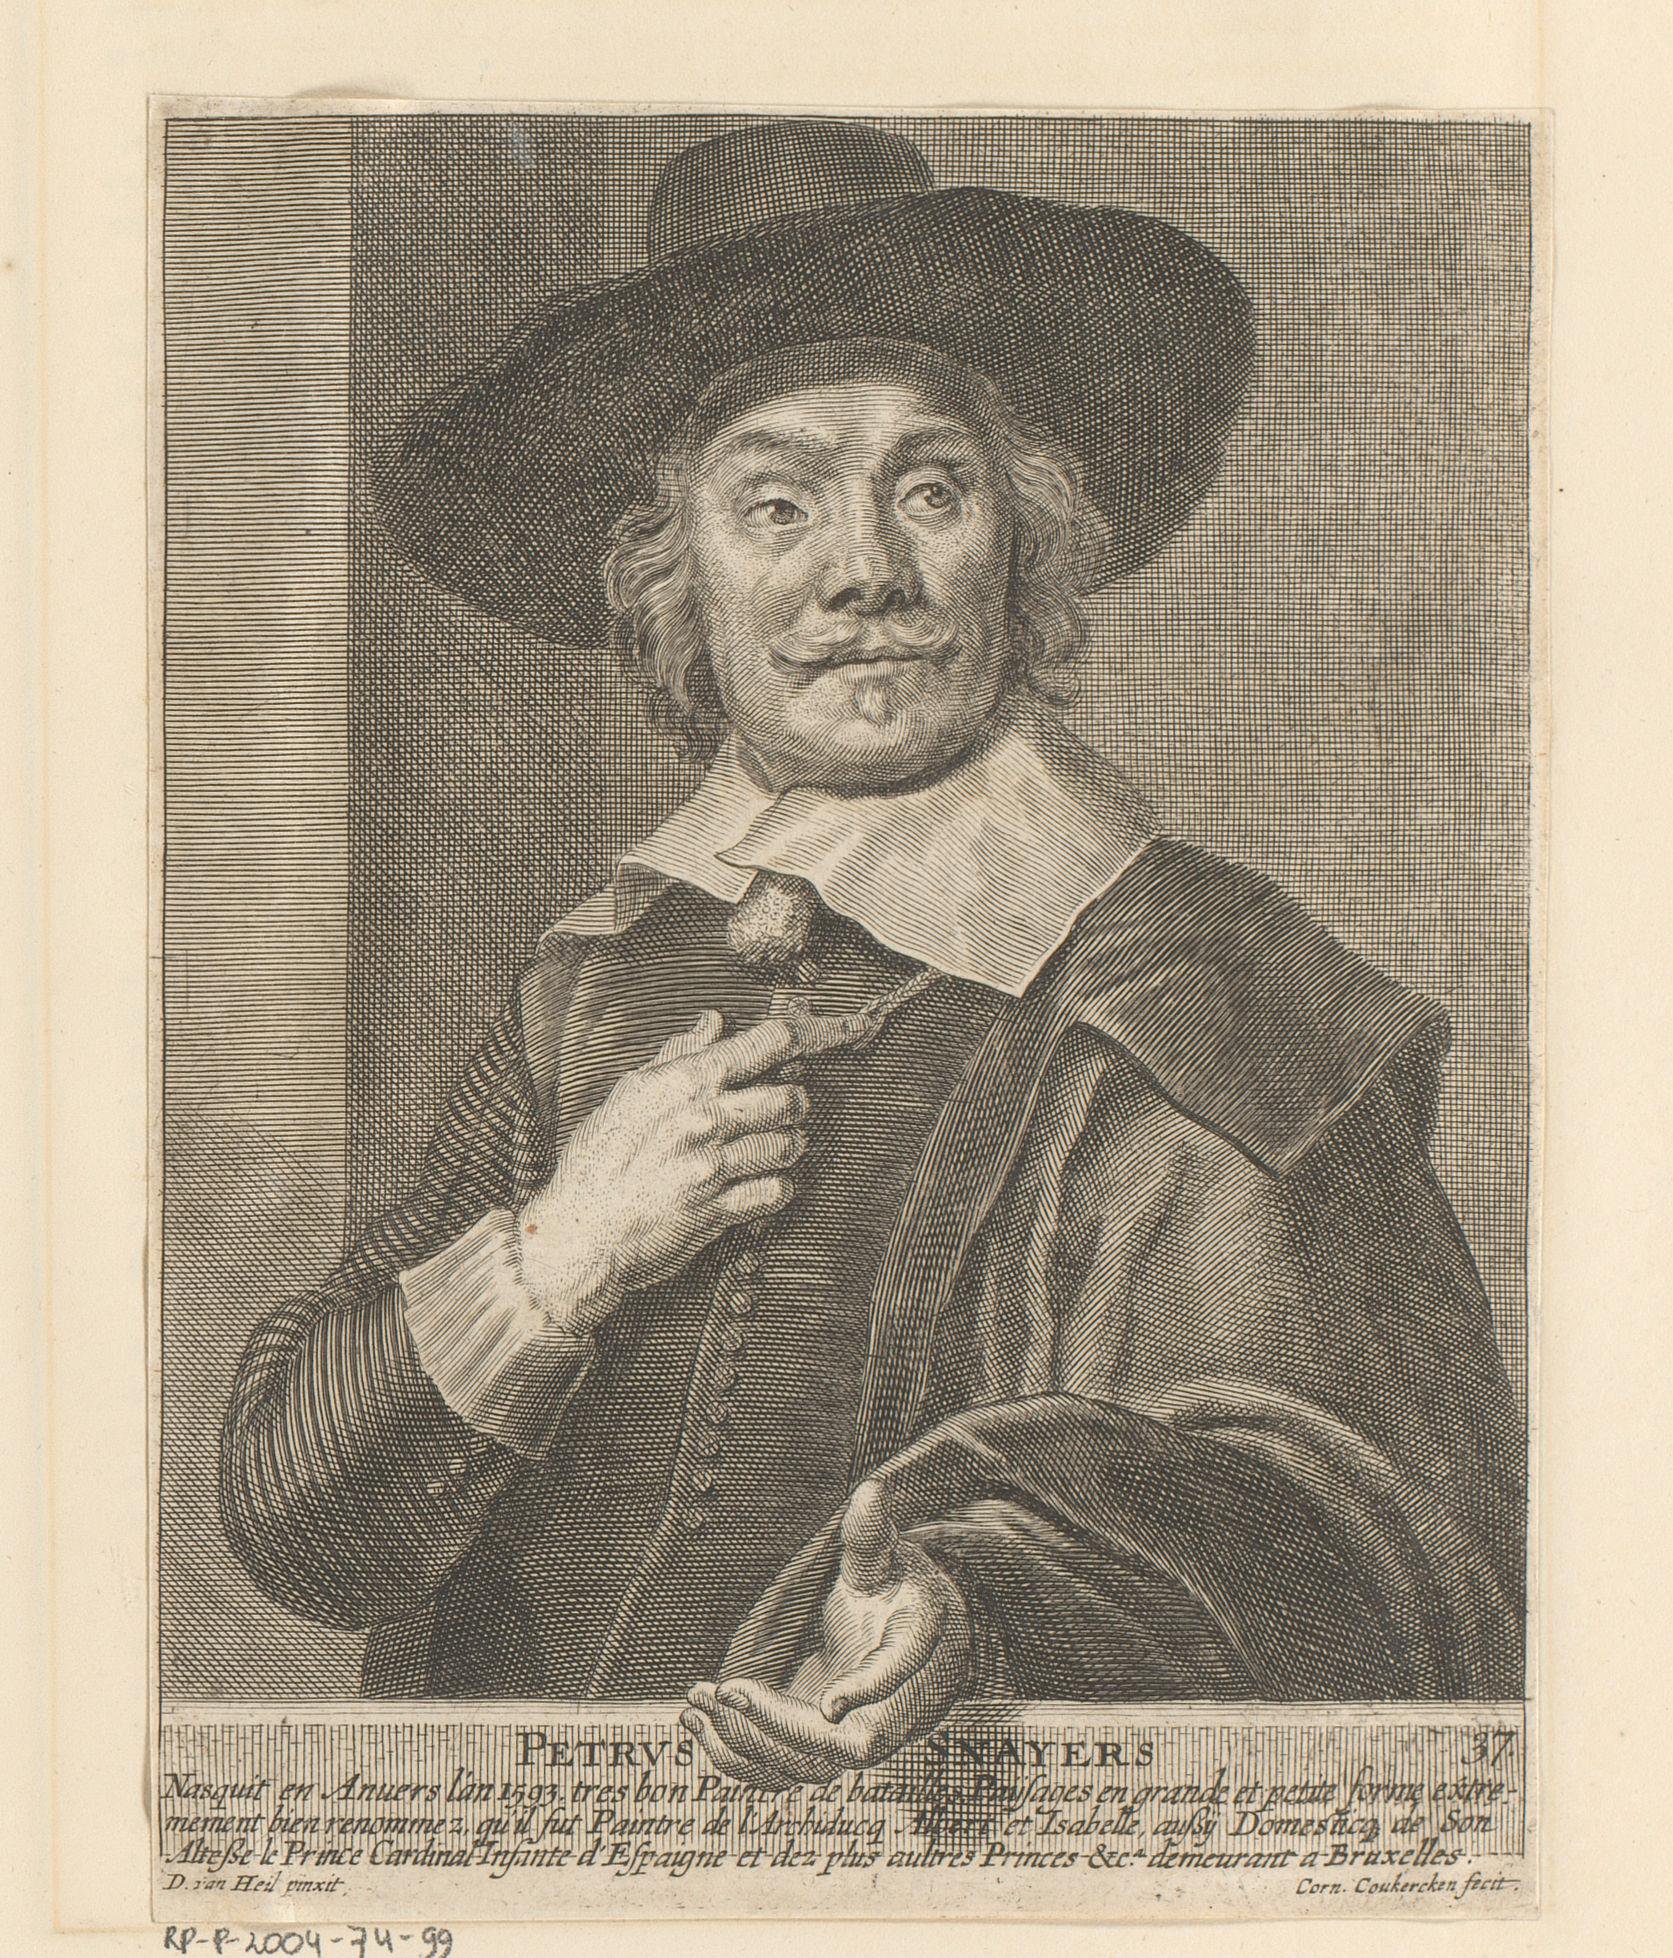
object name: print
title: Portret van Peter Snayers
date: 1649-1662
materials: paper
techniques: engraving, etching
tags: brussels, peeter snayers, historical persons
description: Prent mogelijk uit: Meyssens, Joannes. Image de divers hommes desprit sublime qui par leur art et science deburovent vivre eternellement et des quels la louange et renommée faict estonner le monde. 2 dln. Antwerpen: Joannes Meyssens, 1649, dl. 1, p. 54. Andere staat van prent gebruikt in: Bie, Cornelis De. Het gulden Cabinet vande edel vry schilder const, inhoudende den lof vande vermarste schilders, architecte, beldthowers ende plaetsnyders van dese eeuw. Antwerpen: Joannes Meyssens, 1662 [1661 foutief op titelpagina], p. 221. De samensteller heeft deze prent in het album geplakt als illustratie bij: Pilkington, Matthew en Johann Heinrich Füssli. A dictionary of painters, from the revival of the art to the present period. 4 dln. Londen: John Crowder, 1805, dl. 3, p. 520.